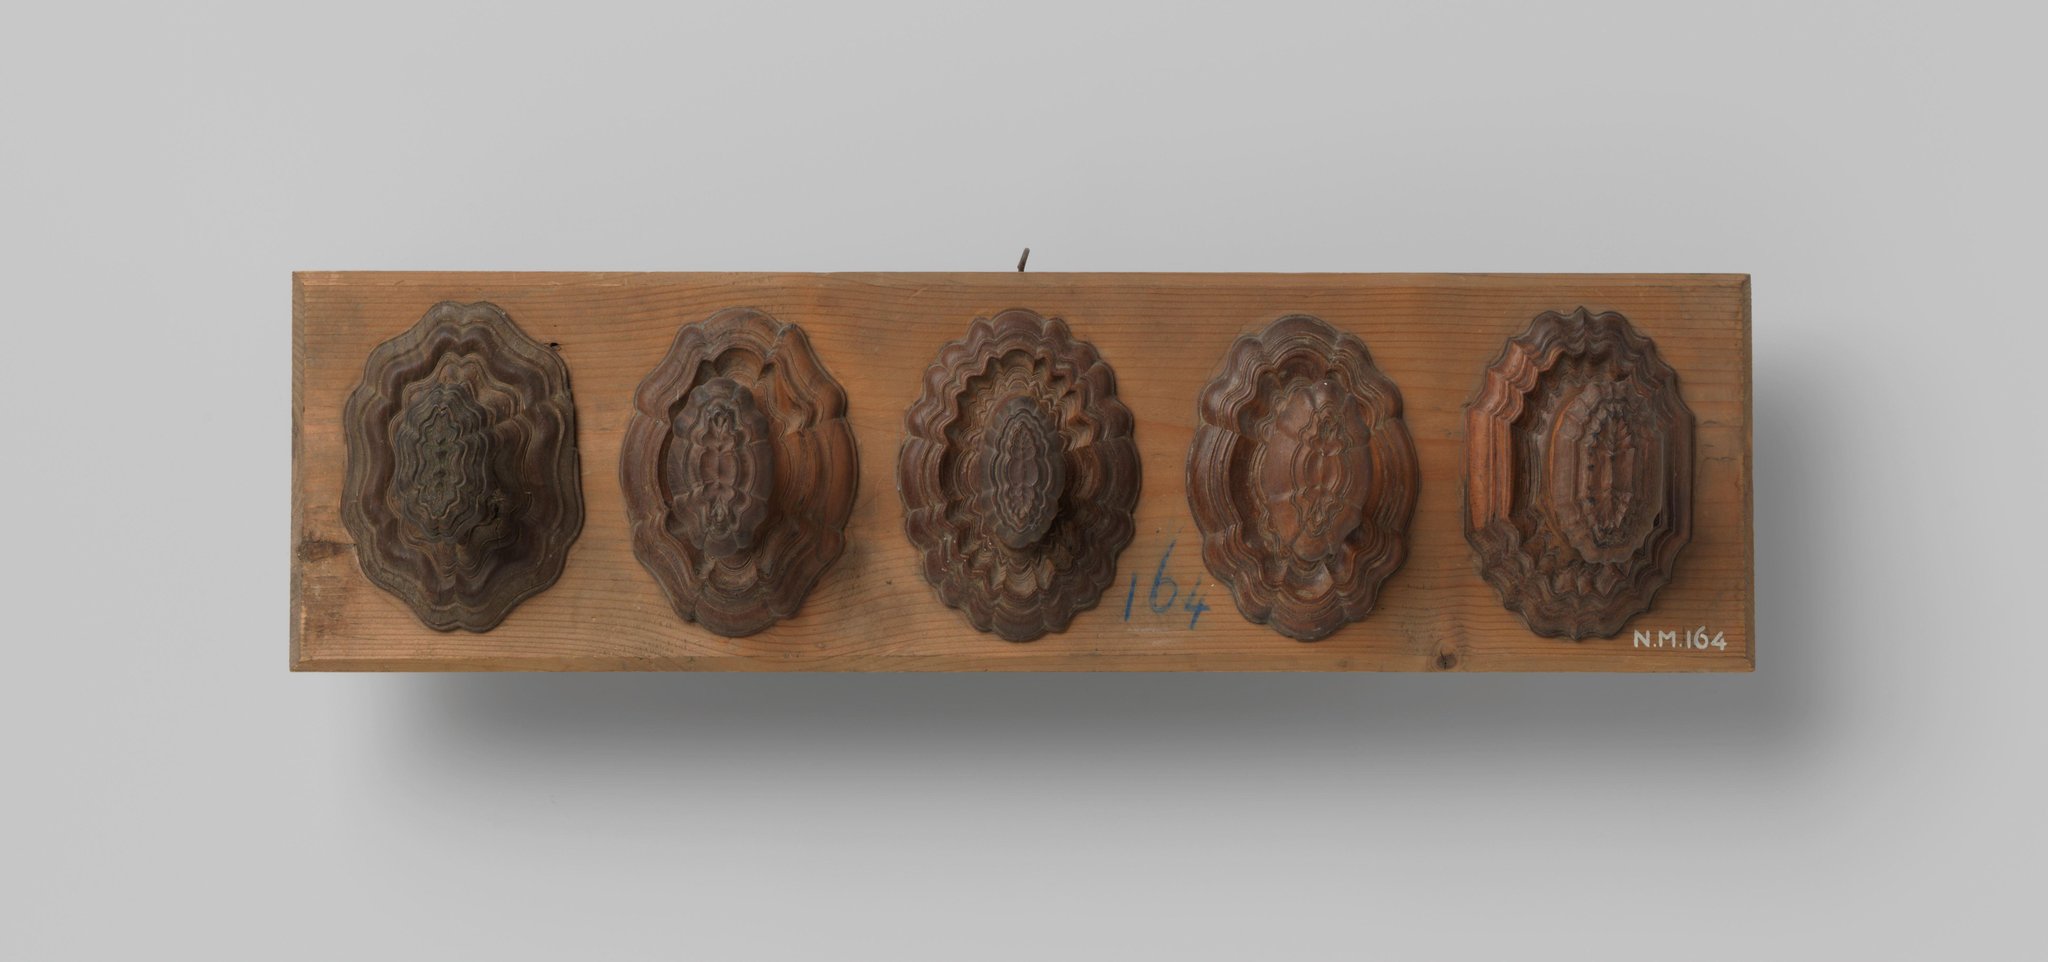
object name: architectural element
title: Deurkruk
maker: Anonymous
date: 1700-1800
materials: wood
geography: netherlands